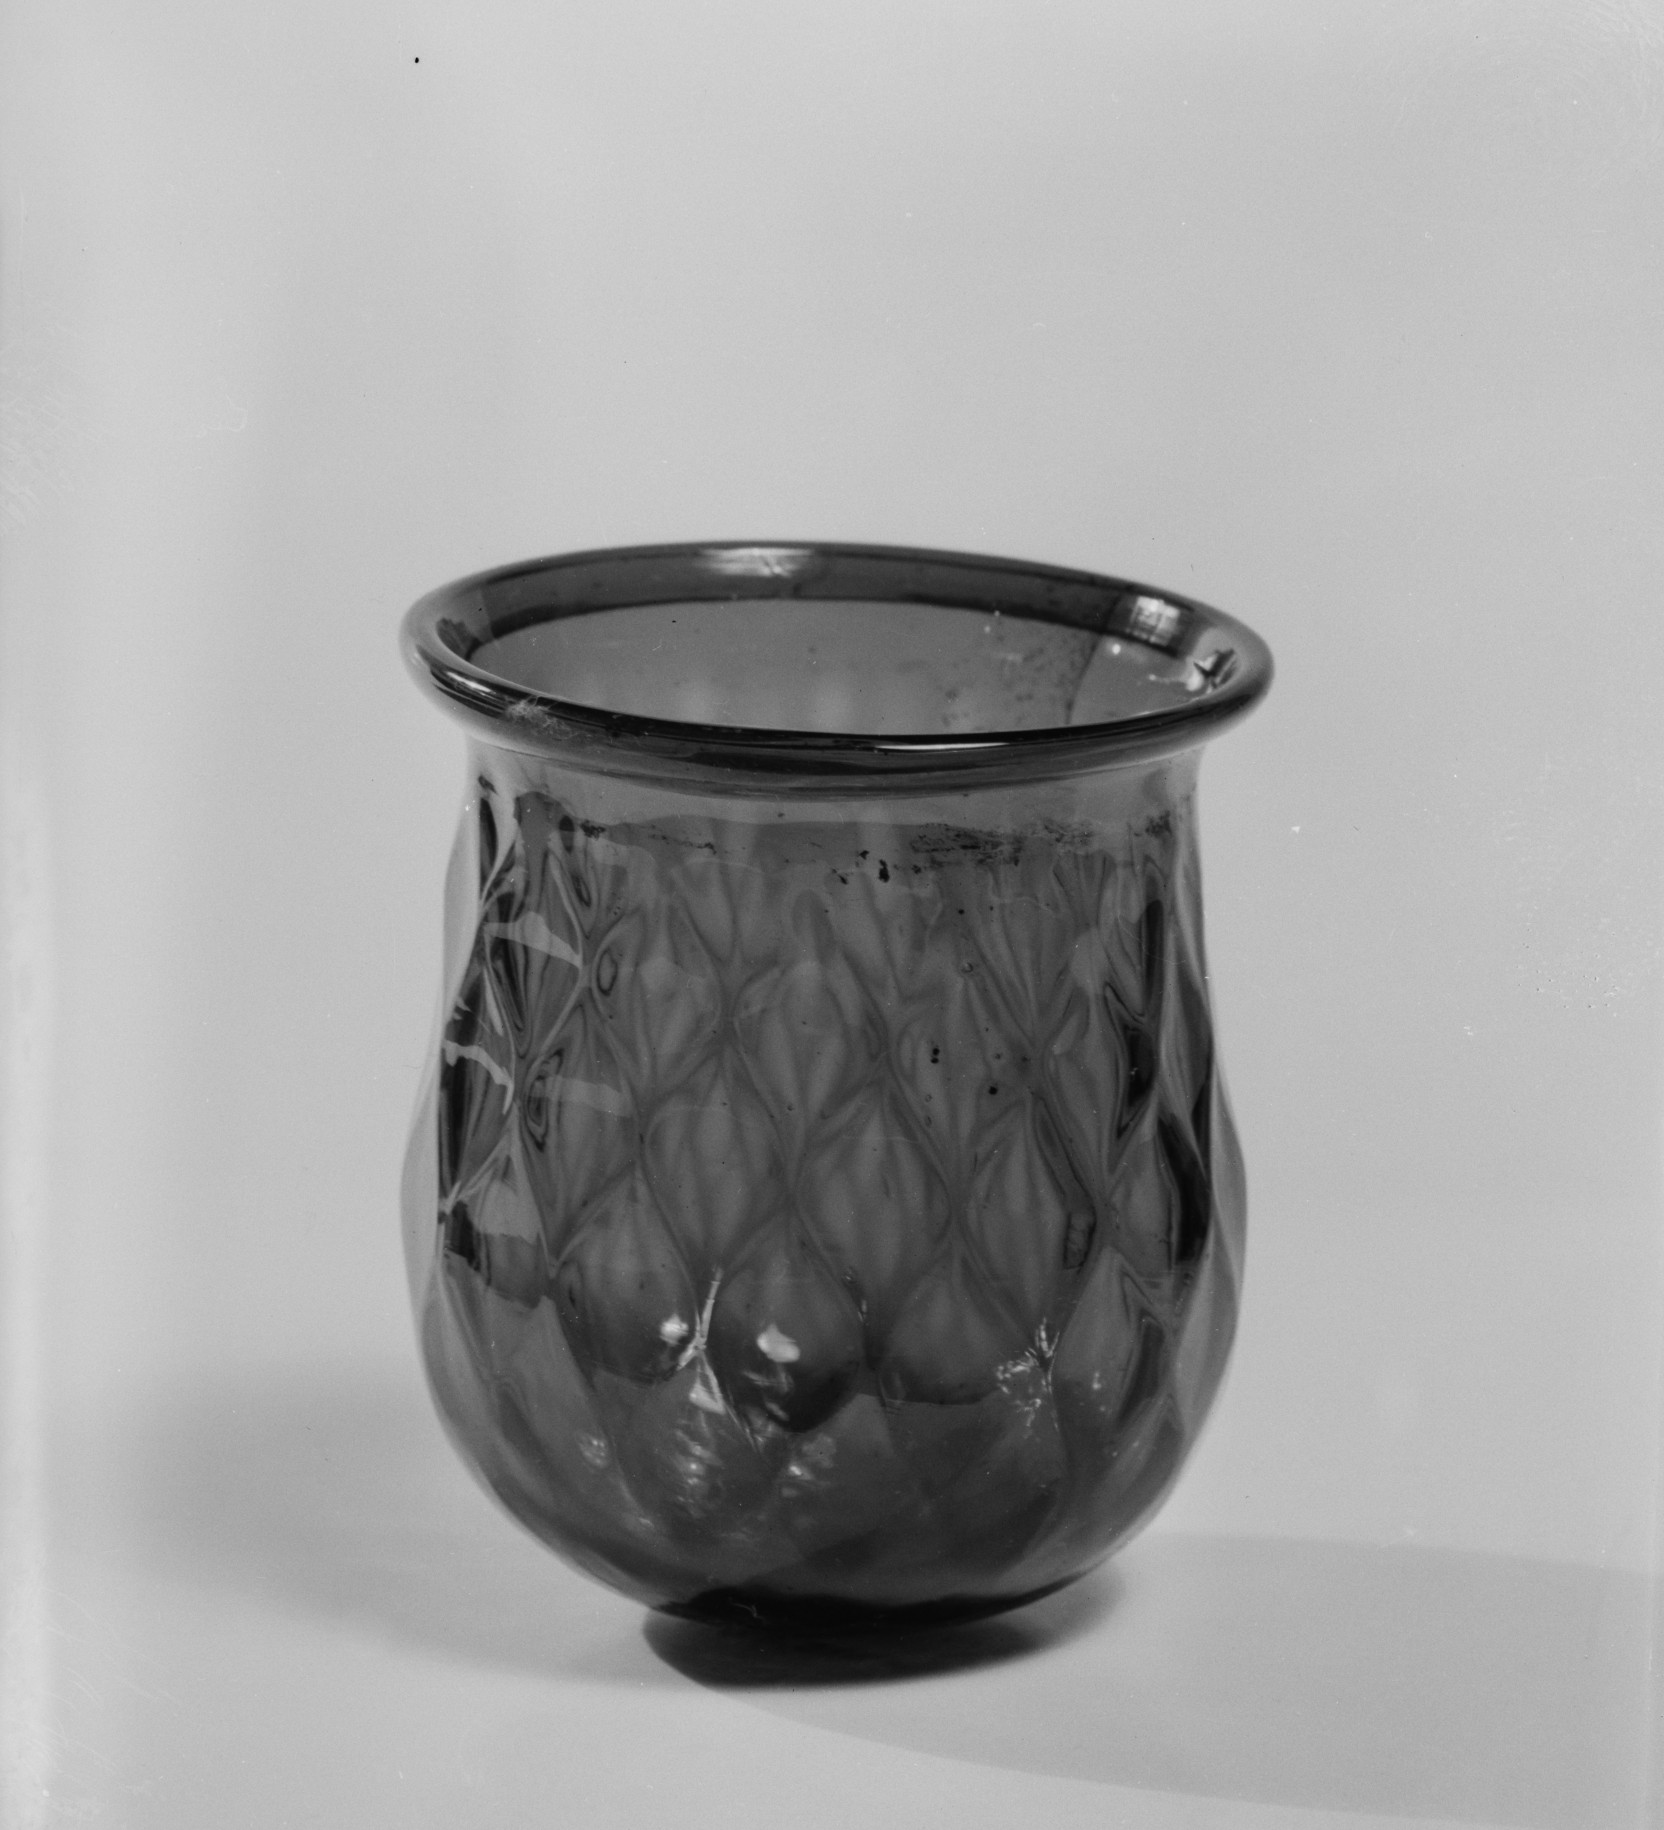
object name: hanging light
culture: american or british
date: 1780-1825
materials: glass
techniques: glassblowing, molding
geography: england